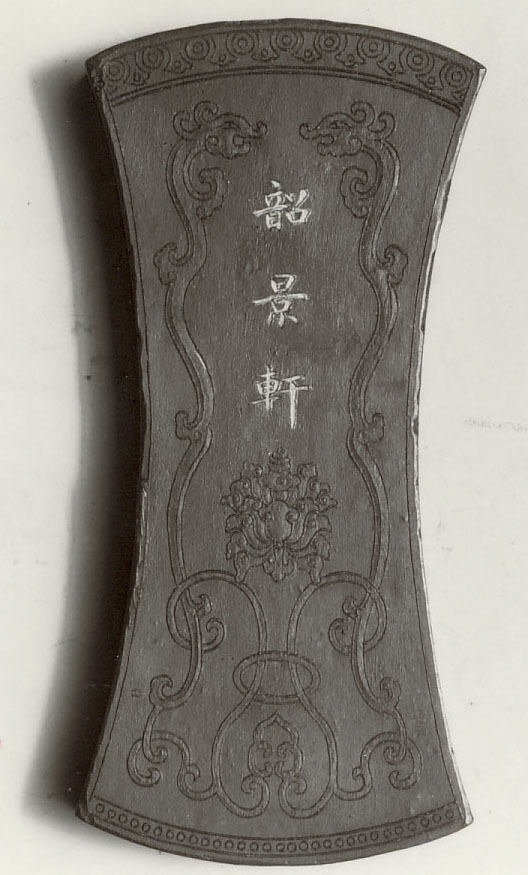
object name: ink tablet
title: Beautiful Scene Pavilion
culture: chinese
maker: jian guzhai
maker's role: artist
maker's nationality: chinese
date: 1867-1933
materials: ink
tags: dragons